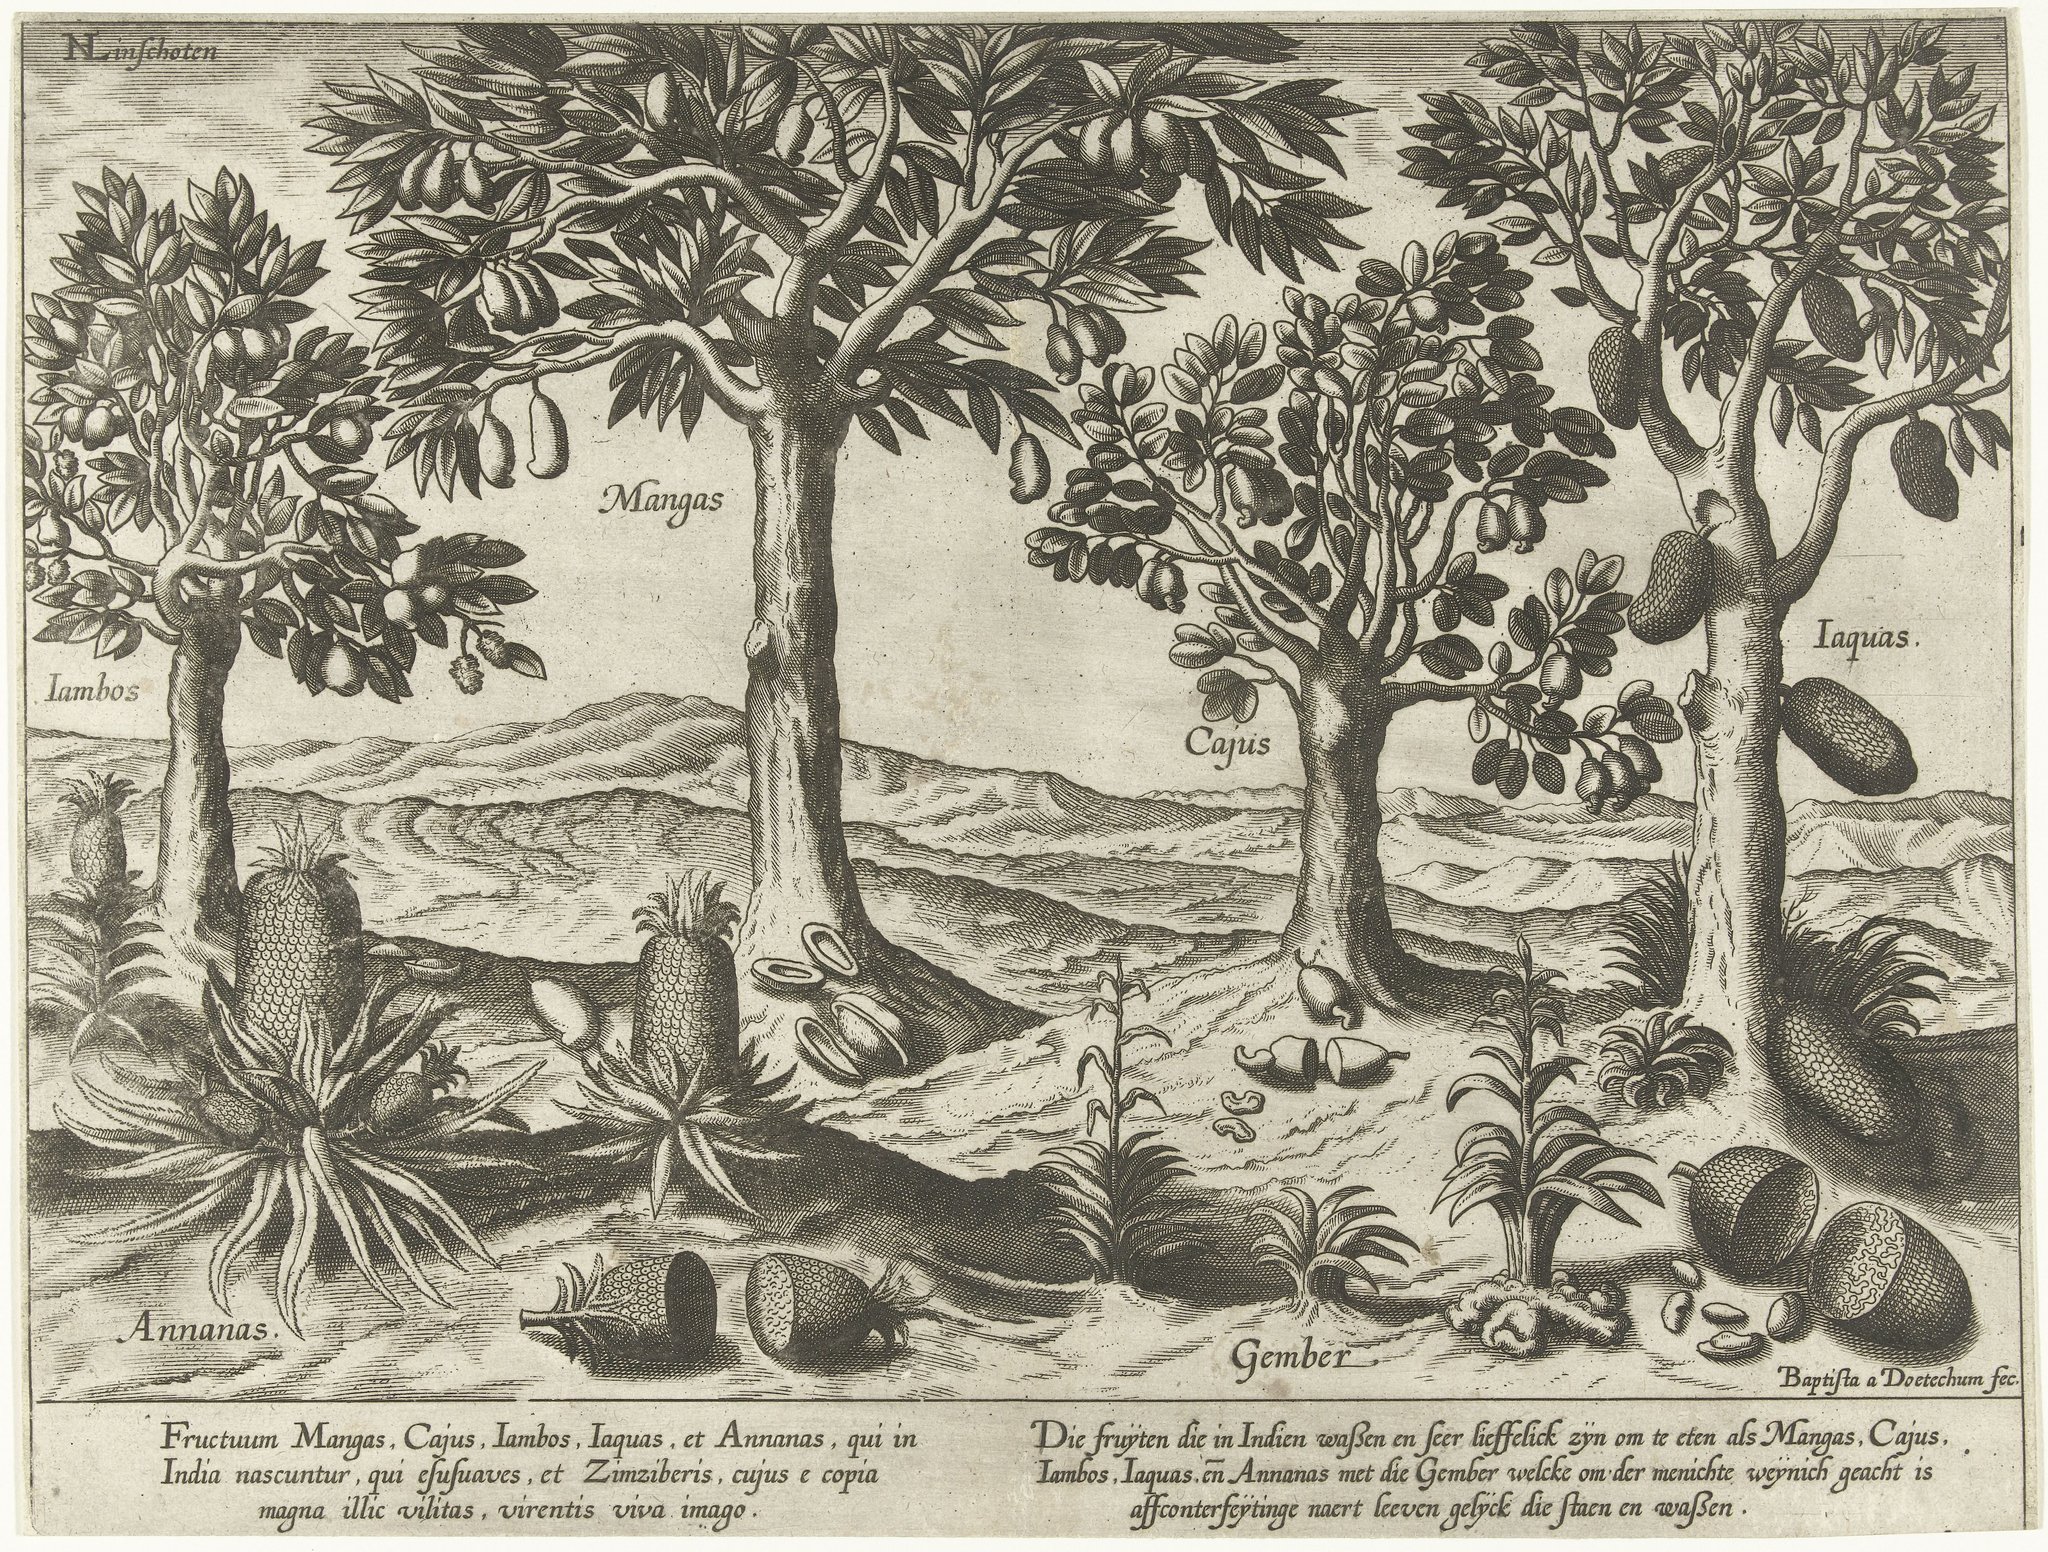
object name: print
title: Fruitbomen en -struiken uit Oost-Indië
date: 1596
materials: paper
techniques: engraving, etching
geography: haarlem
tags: fruit-tree culture; fruit harvest, fruits: nuts, fruits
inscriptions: collector's mark: Lugt 2760, collector's mark: Lugt 2228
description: op Holl. graveurs. Illustratie uit: J.H. van Linschoten. Itinerario, voyage ofte schipvaert van Jan Huygen van Linschoten naer Oost ofte Portugaels Indien. Amsterdam: Cornelis Claesz, 1596; of latere editie.